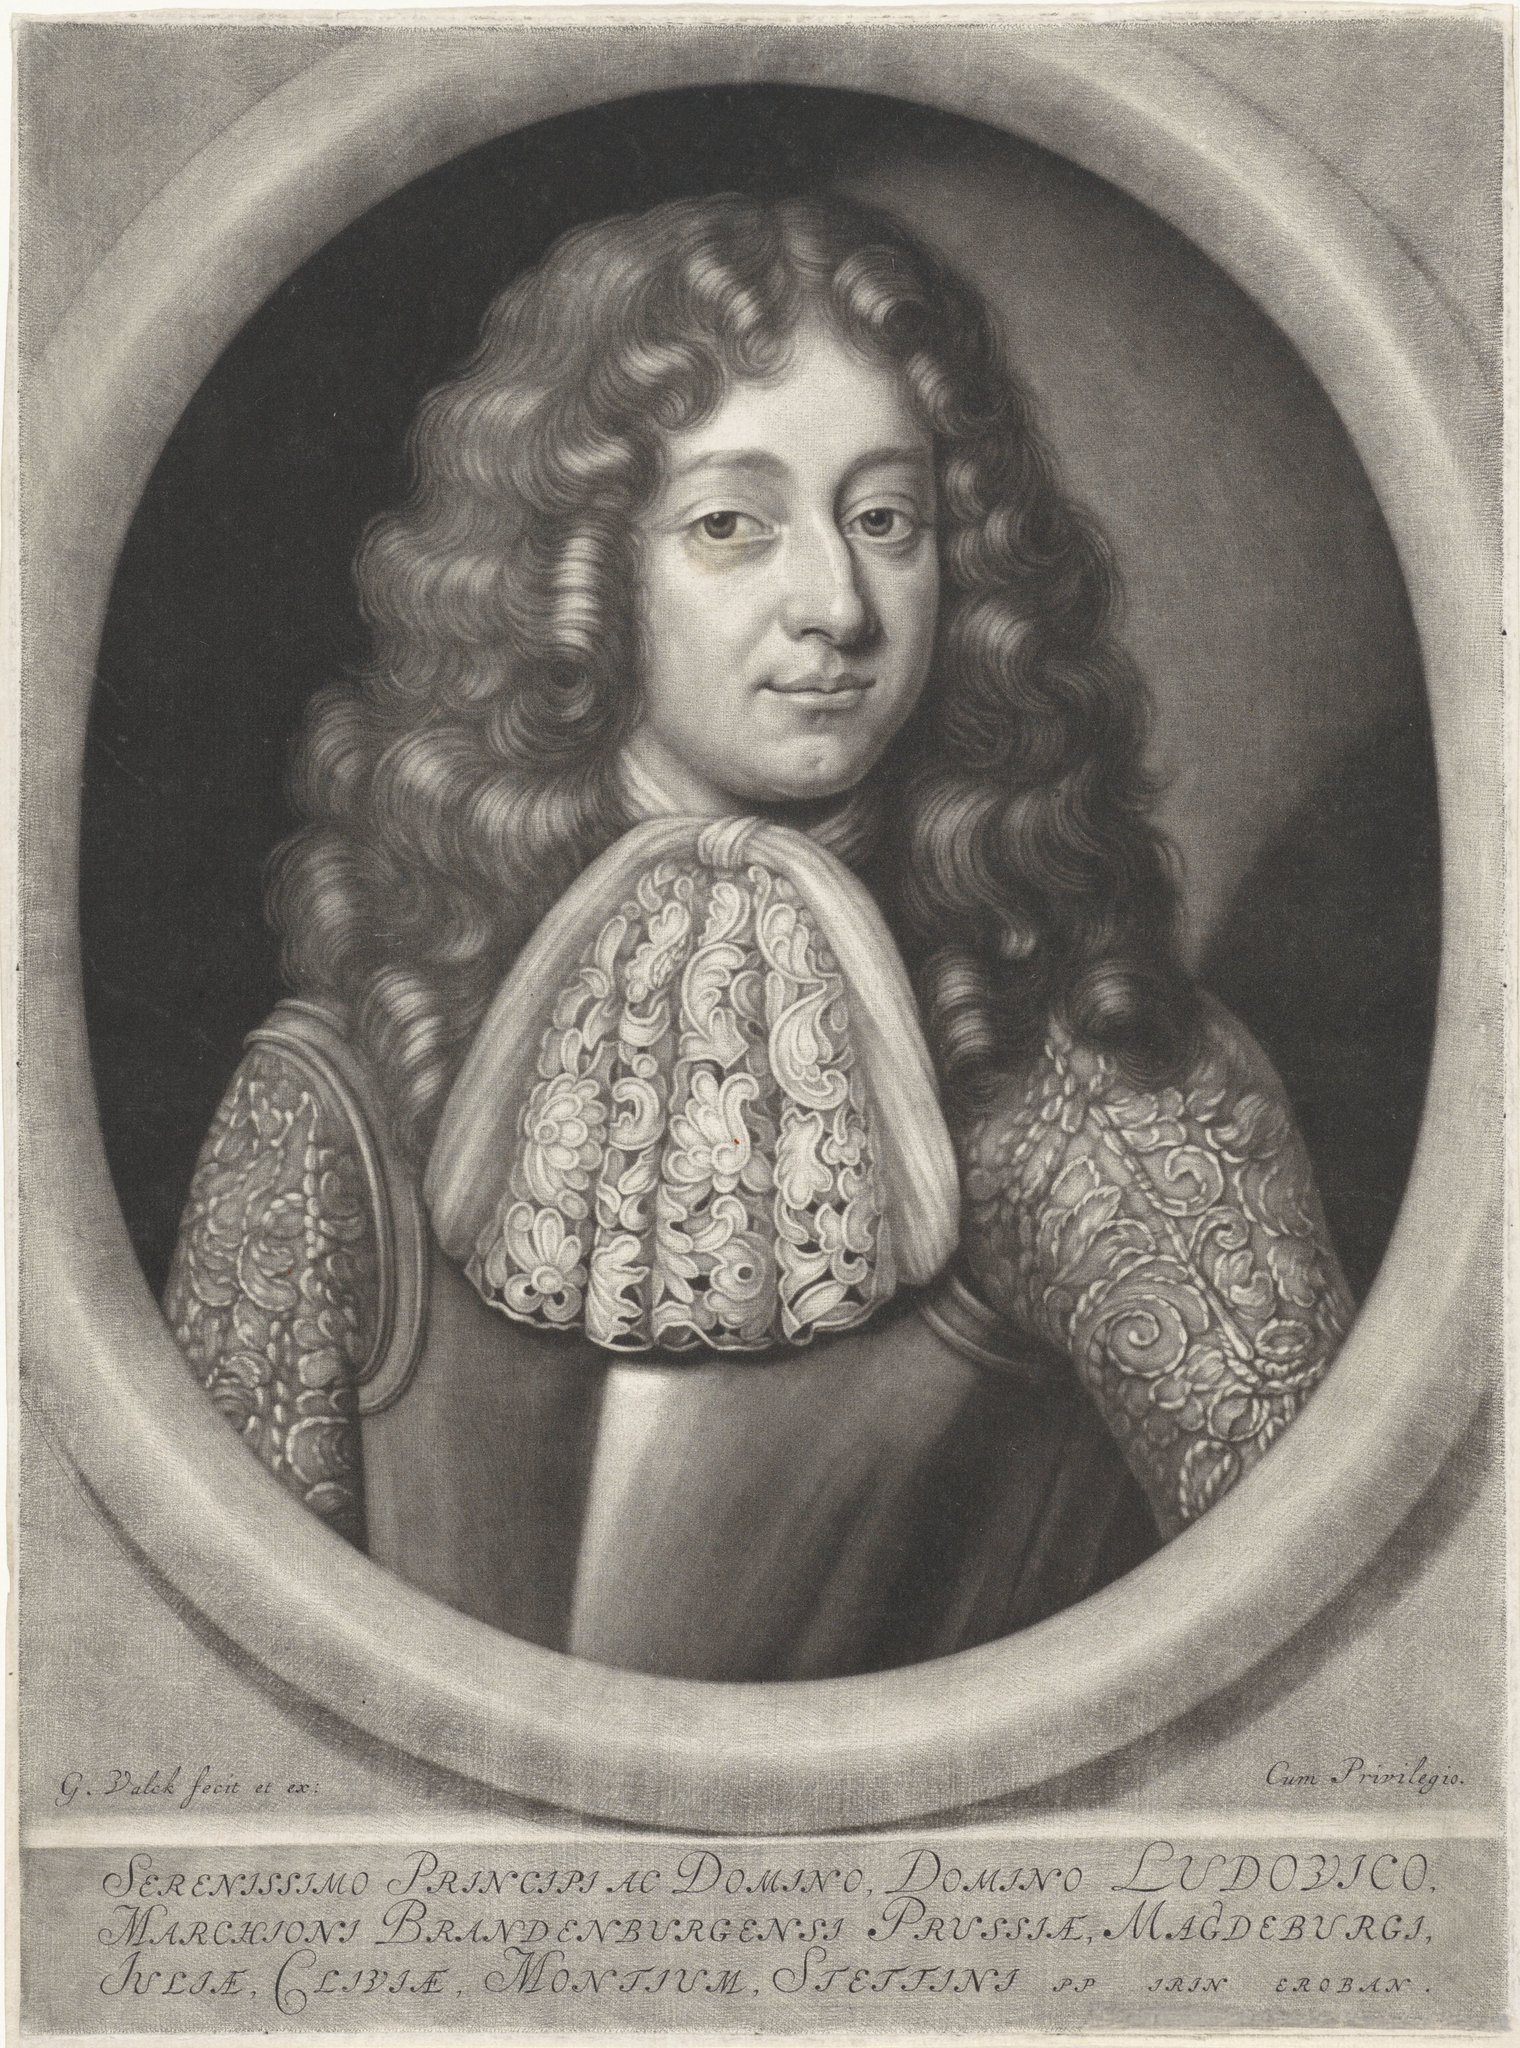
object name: print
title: Portret van Lodewijk, markgraaf van Brandenburg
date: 1662-1726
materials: paper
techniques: mezzotint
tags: lodewijk (markgraaf van brandenburg)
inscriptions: collector's mark: Lugt 2228, collector's mark: Lugt 2922, collector's mark: Lugt 1616, collector's mark: Lugt 1618